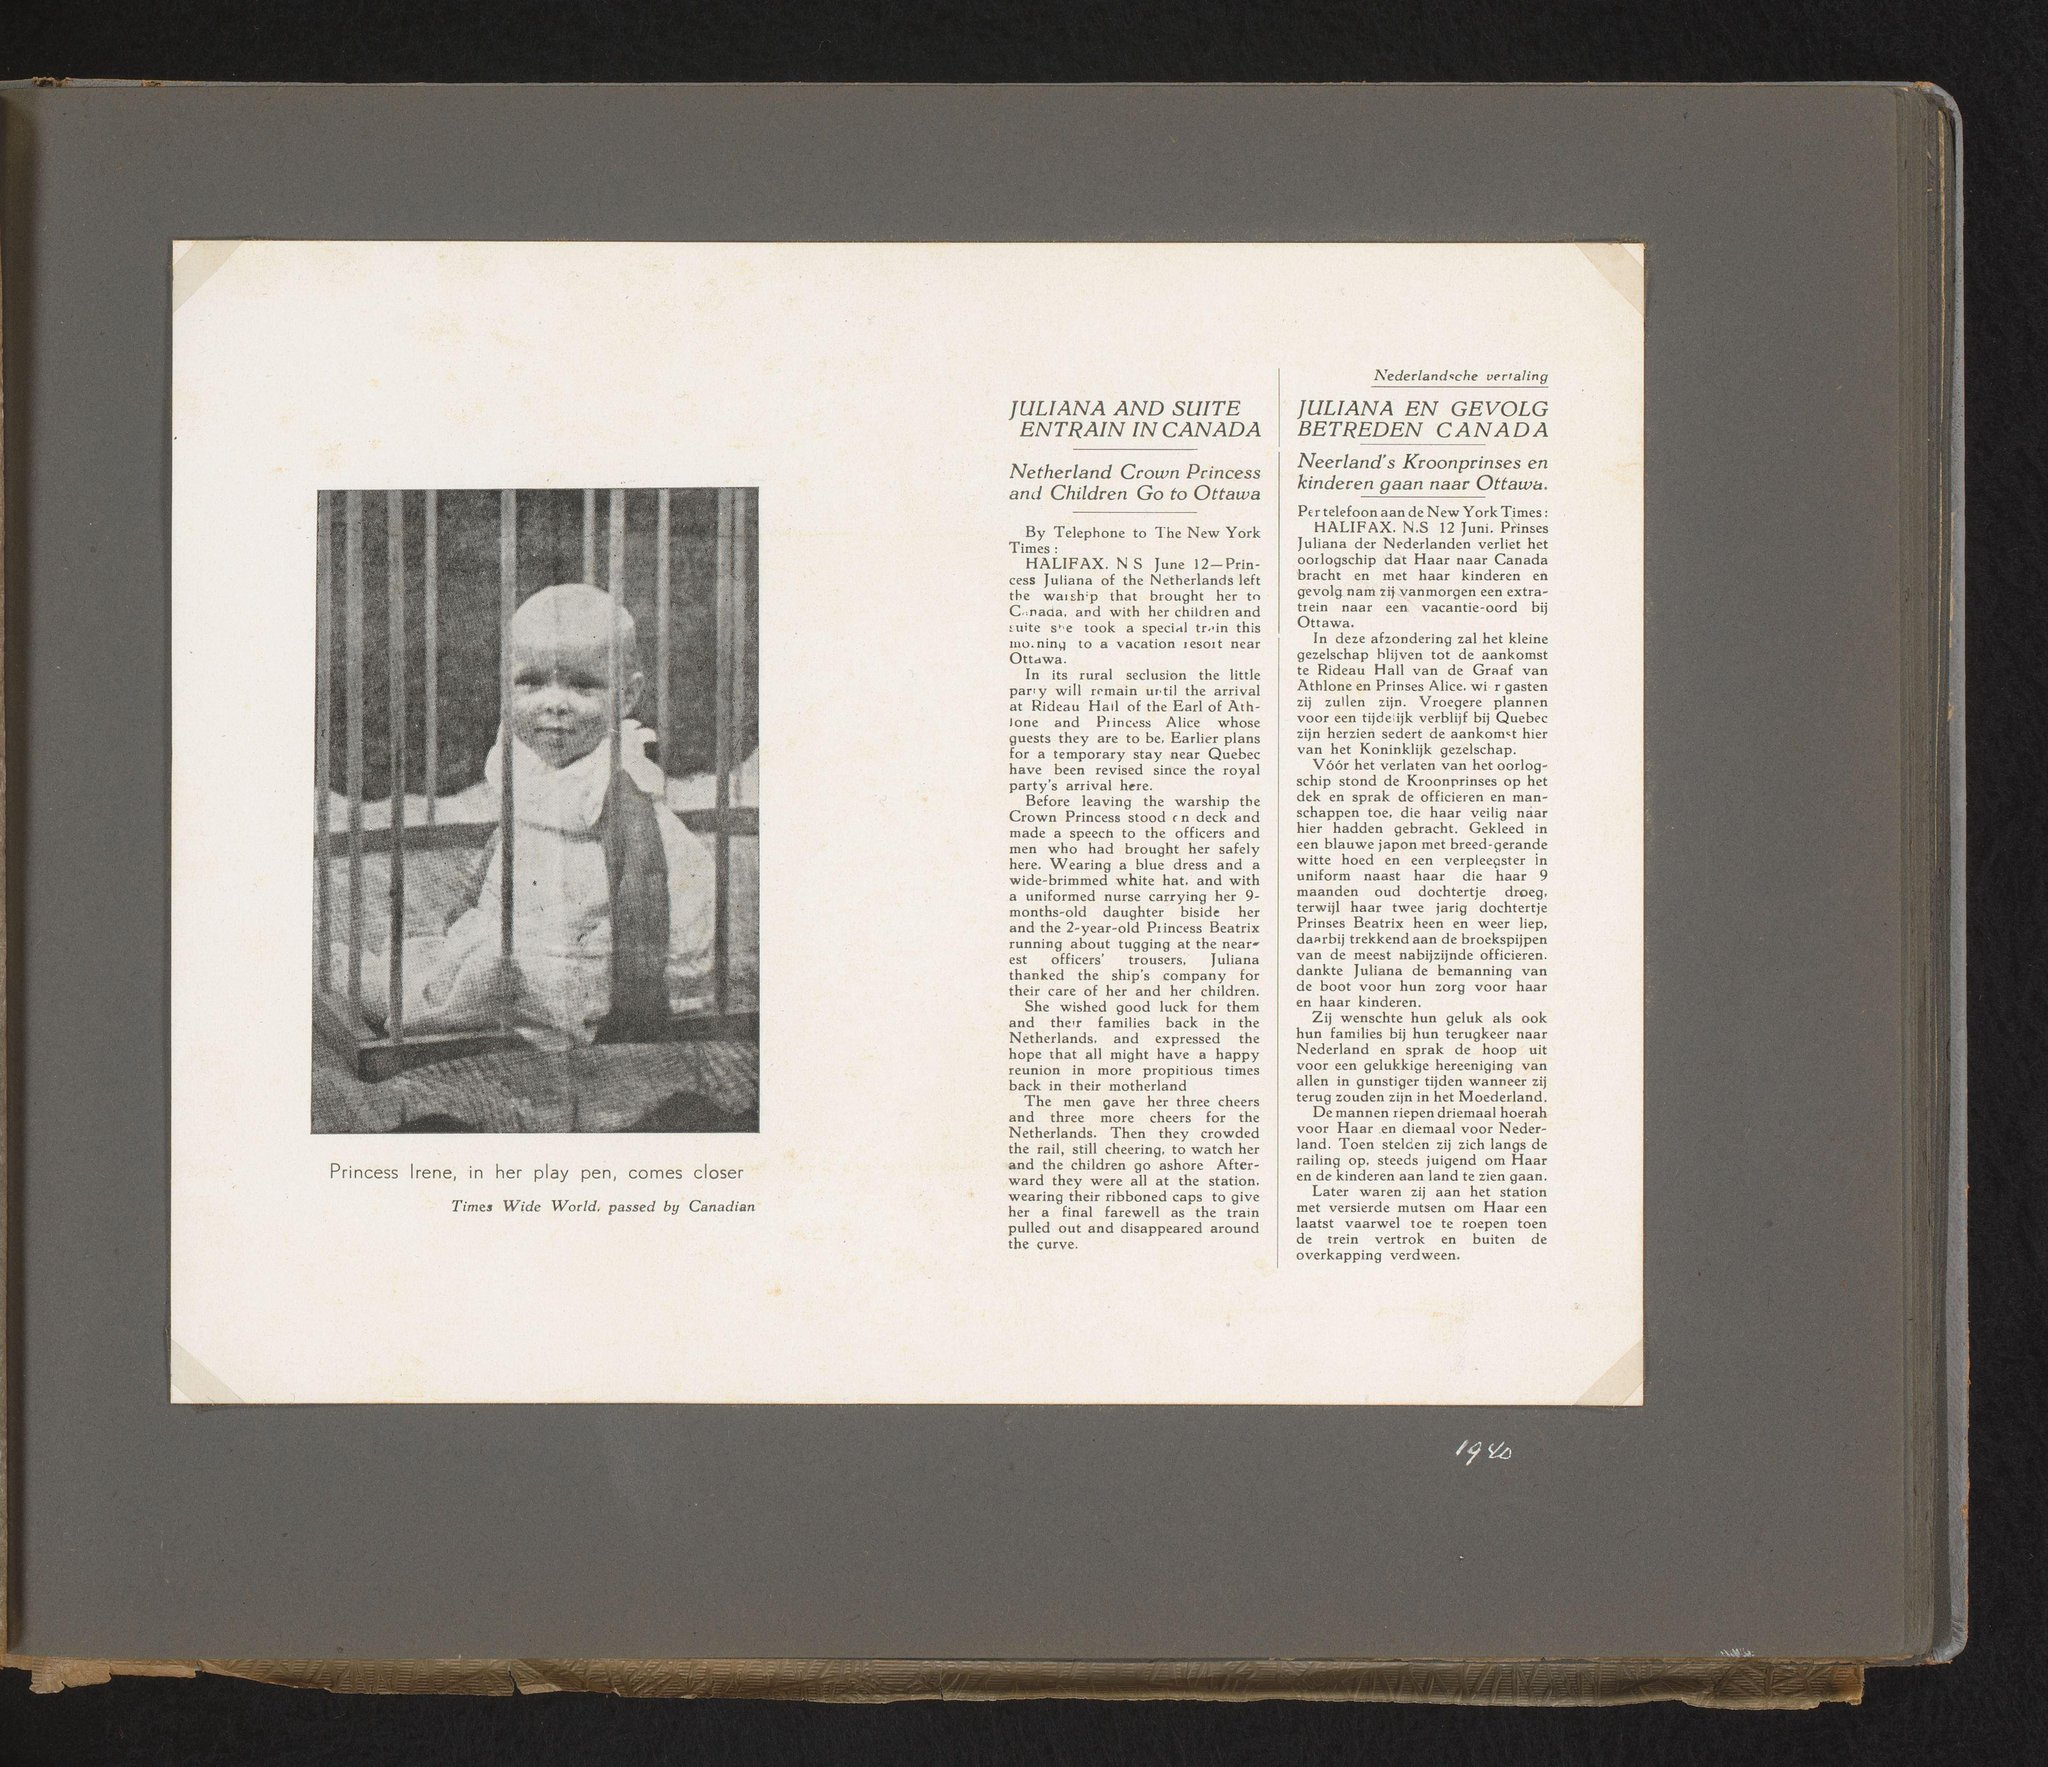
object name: reproduction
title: Princess Irene, in her play pen, comes closer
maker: Anonymous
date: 1940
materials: cardboard, paper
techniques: screen printed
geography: canada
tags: beatrix (koningin der nederlanden), the hague, juliana of the netherlands, parents with their children, canada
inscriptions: inscription: ‘1940’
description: Albumblad met een reproductie van een foto met begeleidend krantenartikel: prinses Irene in een box, Canada 1940. Onderdeel van fotoalbum over het familieleven van de leden van het Koninklijk Huis tussen 1937-1945.